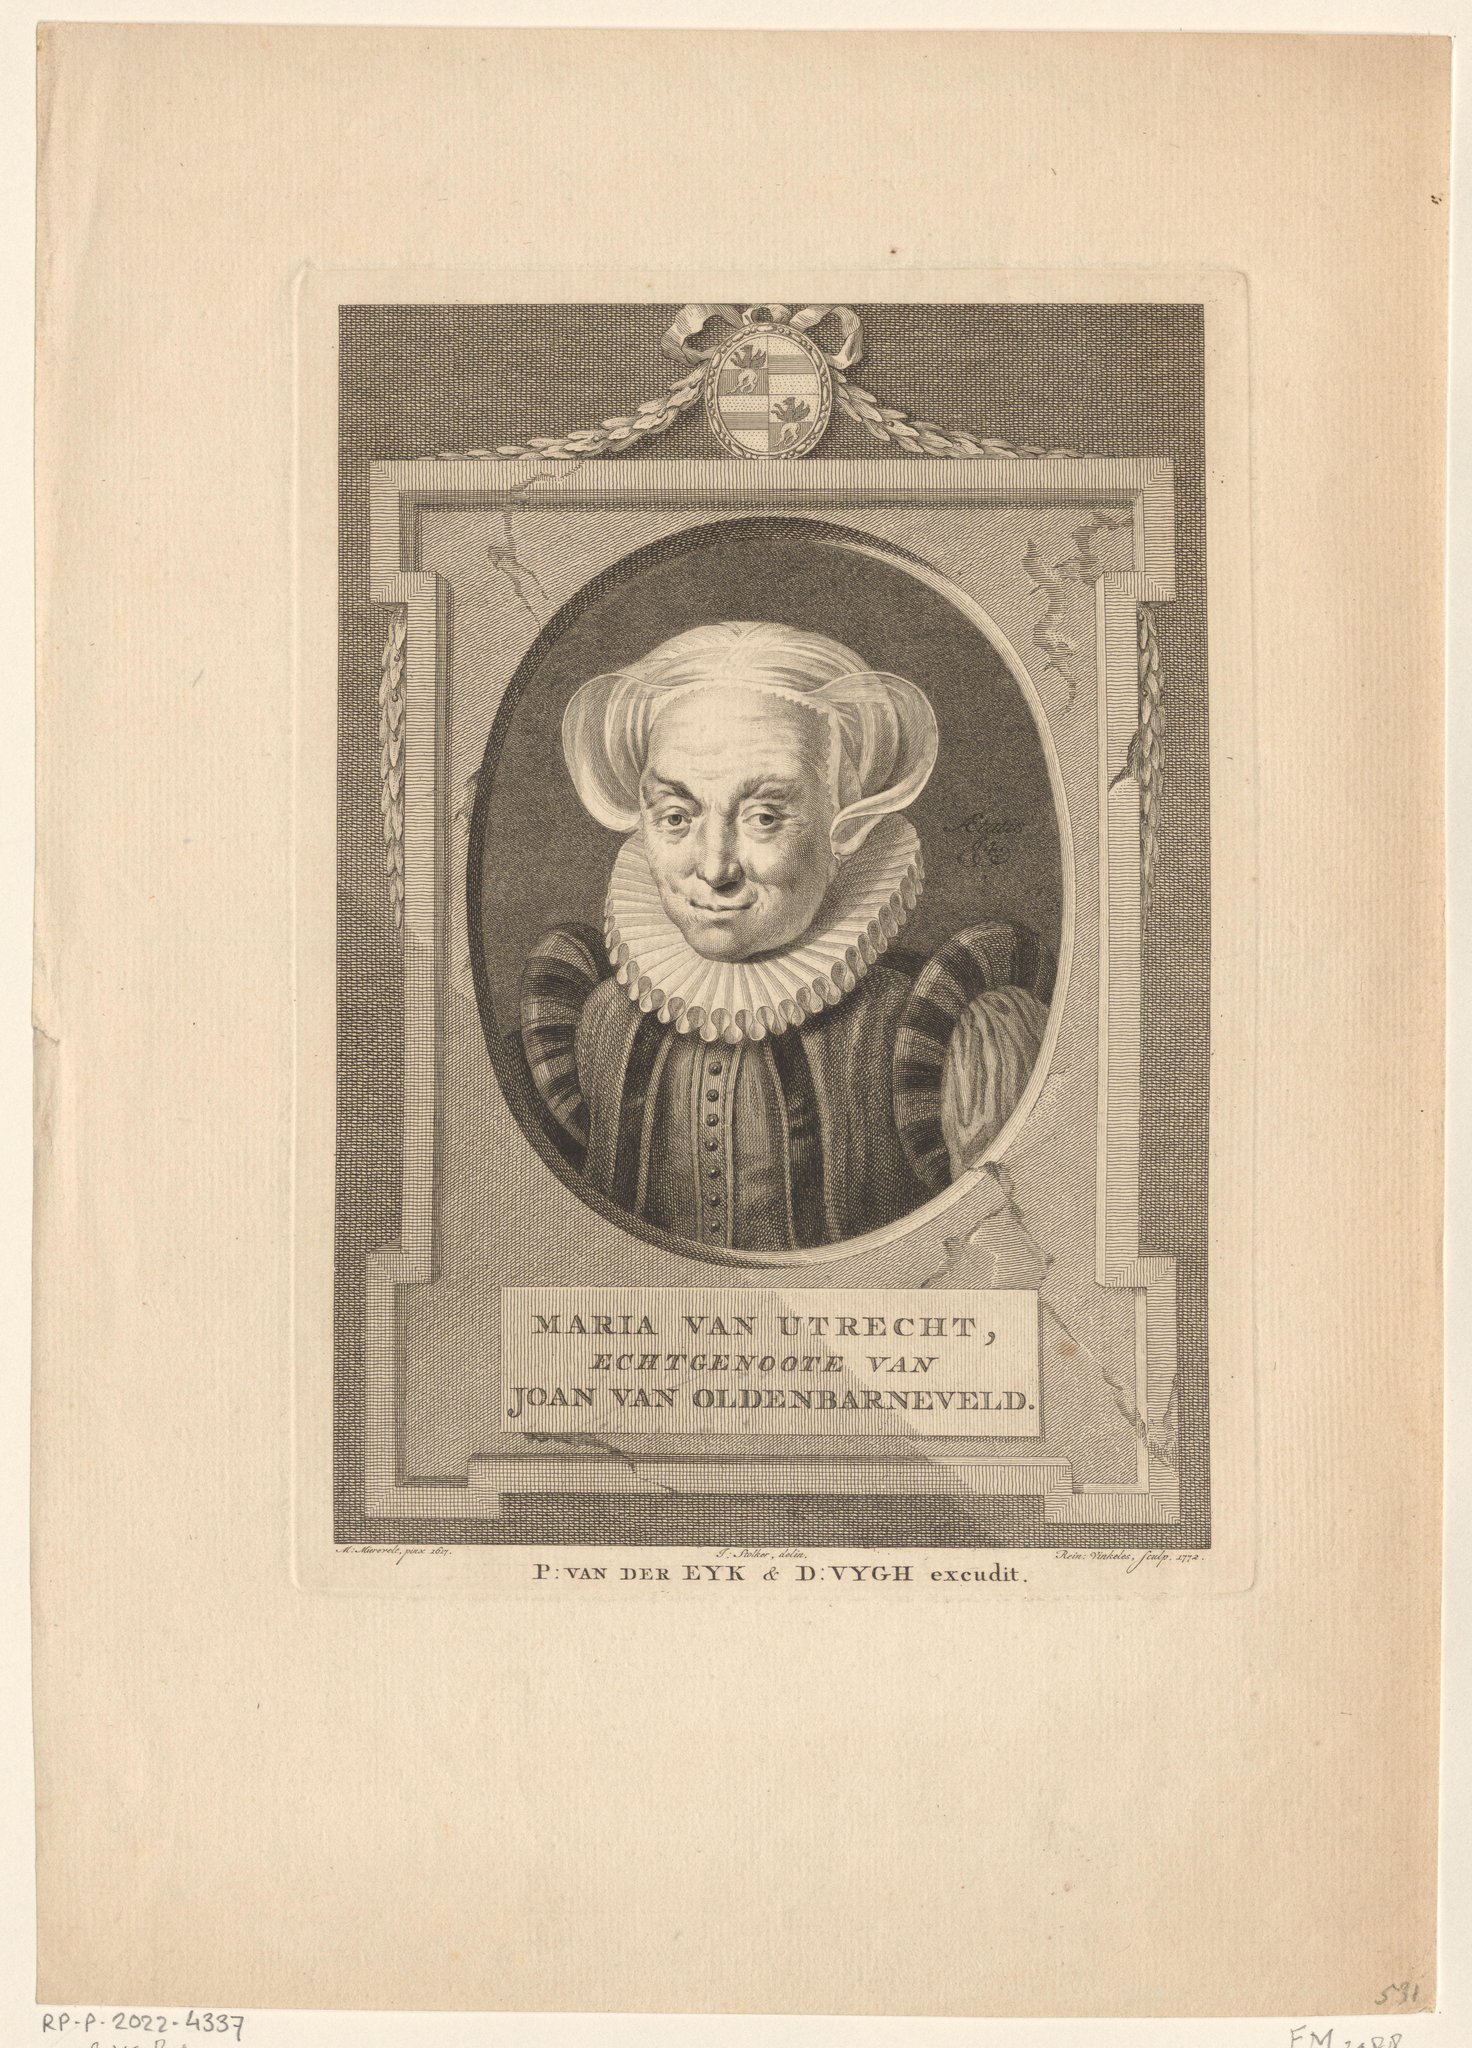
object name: print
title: Portret van Maria van Utrecht op 64-jarige leeftijd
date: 1772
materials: paper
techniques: engraving, etching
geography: leiden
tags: historical persons - bb - woman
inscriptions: collector's mark: Lugt 2228